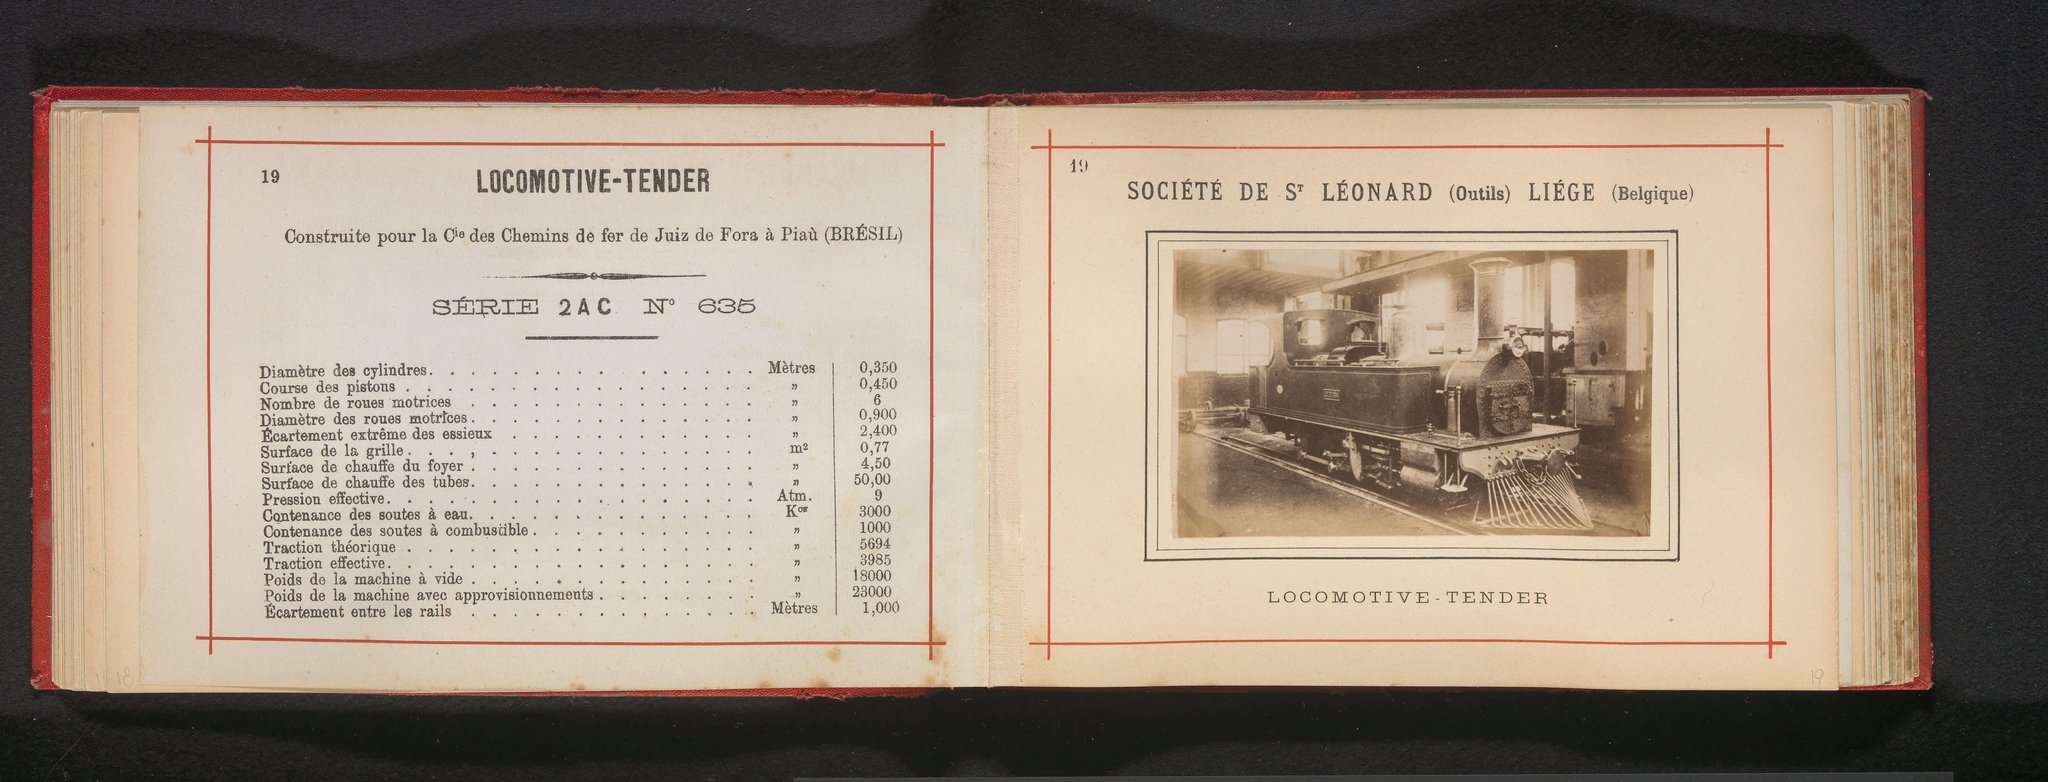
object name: page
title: Locomotive-tender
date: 1880-1885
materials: photographic support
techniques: albumen print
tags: locomotive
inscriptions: inscription: ‘Société de St. Léonard (Outils) Liége (Belgique)’